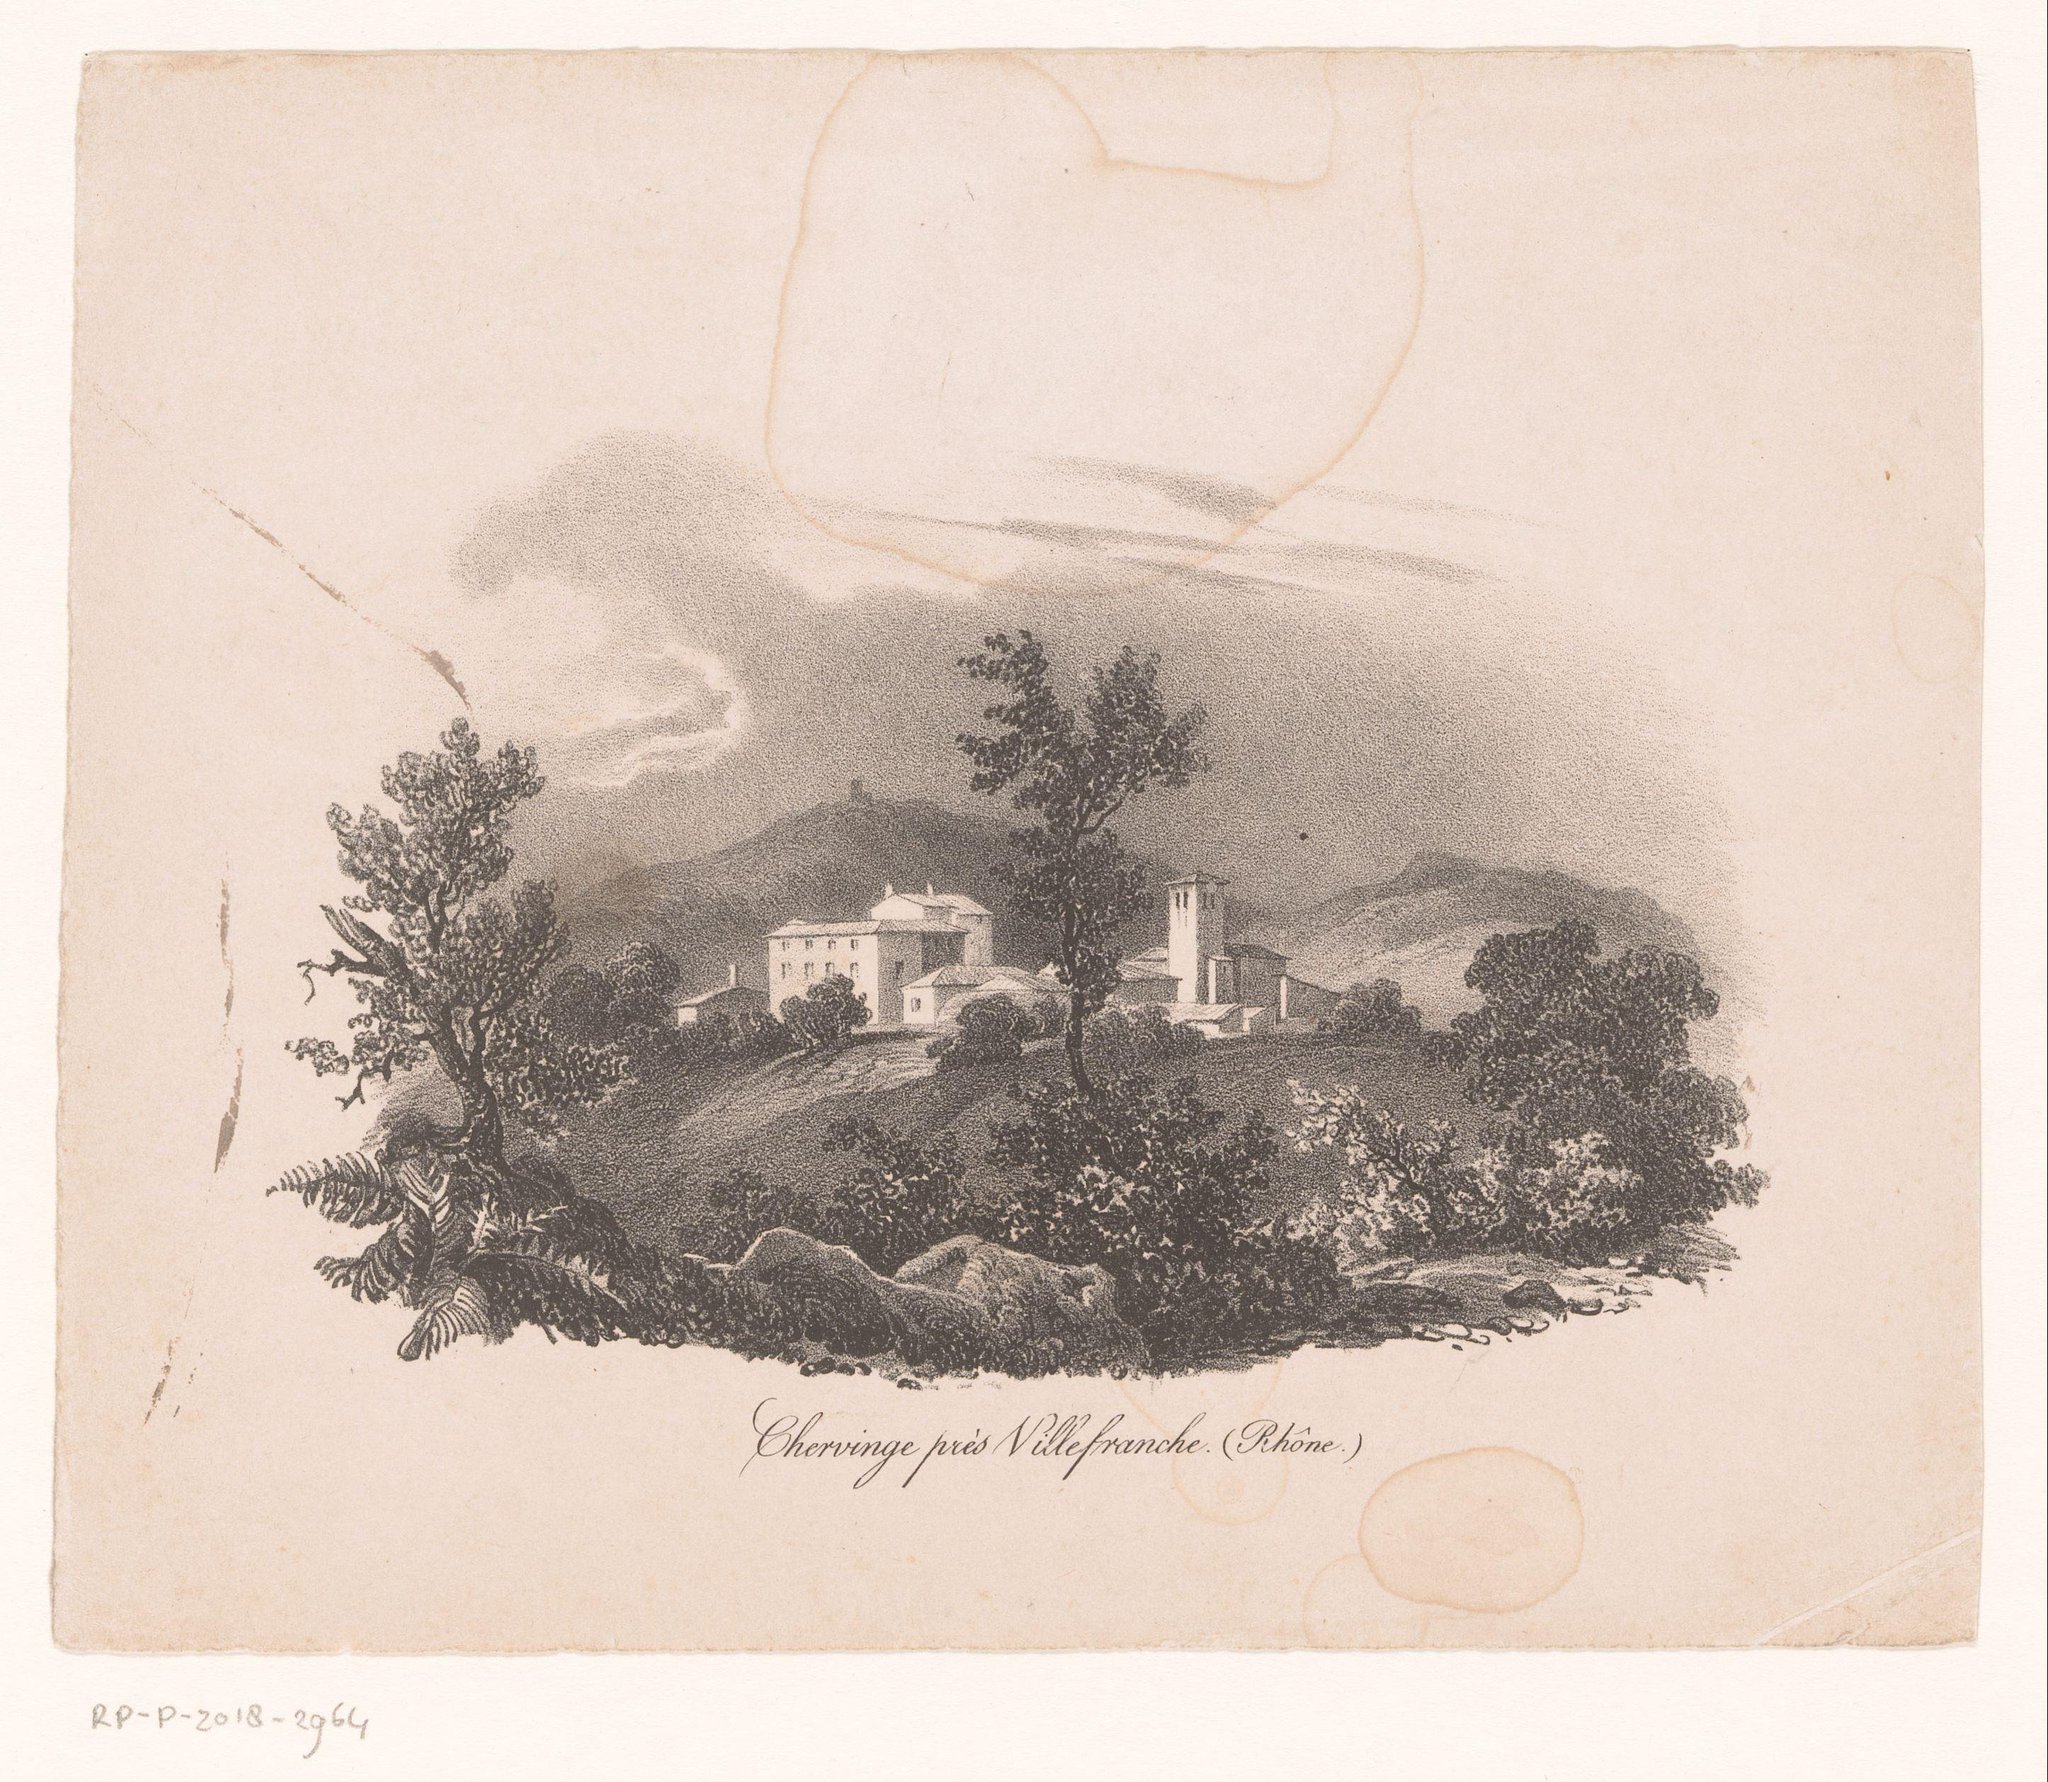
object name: print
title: Gezicht op Chervinge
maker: Anonymous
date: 1820-1860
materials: paper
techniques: lithograph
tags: prospect of city, town panorama, silhouette of city, france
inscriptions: collector's mark: Lugt 2228